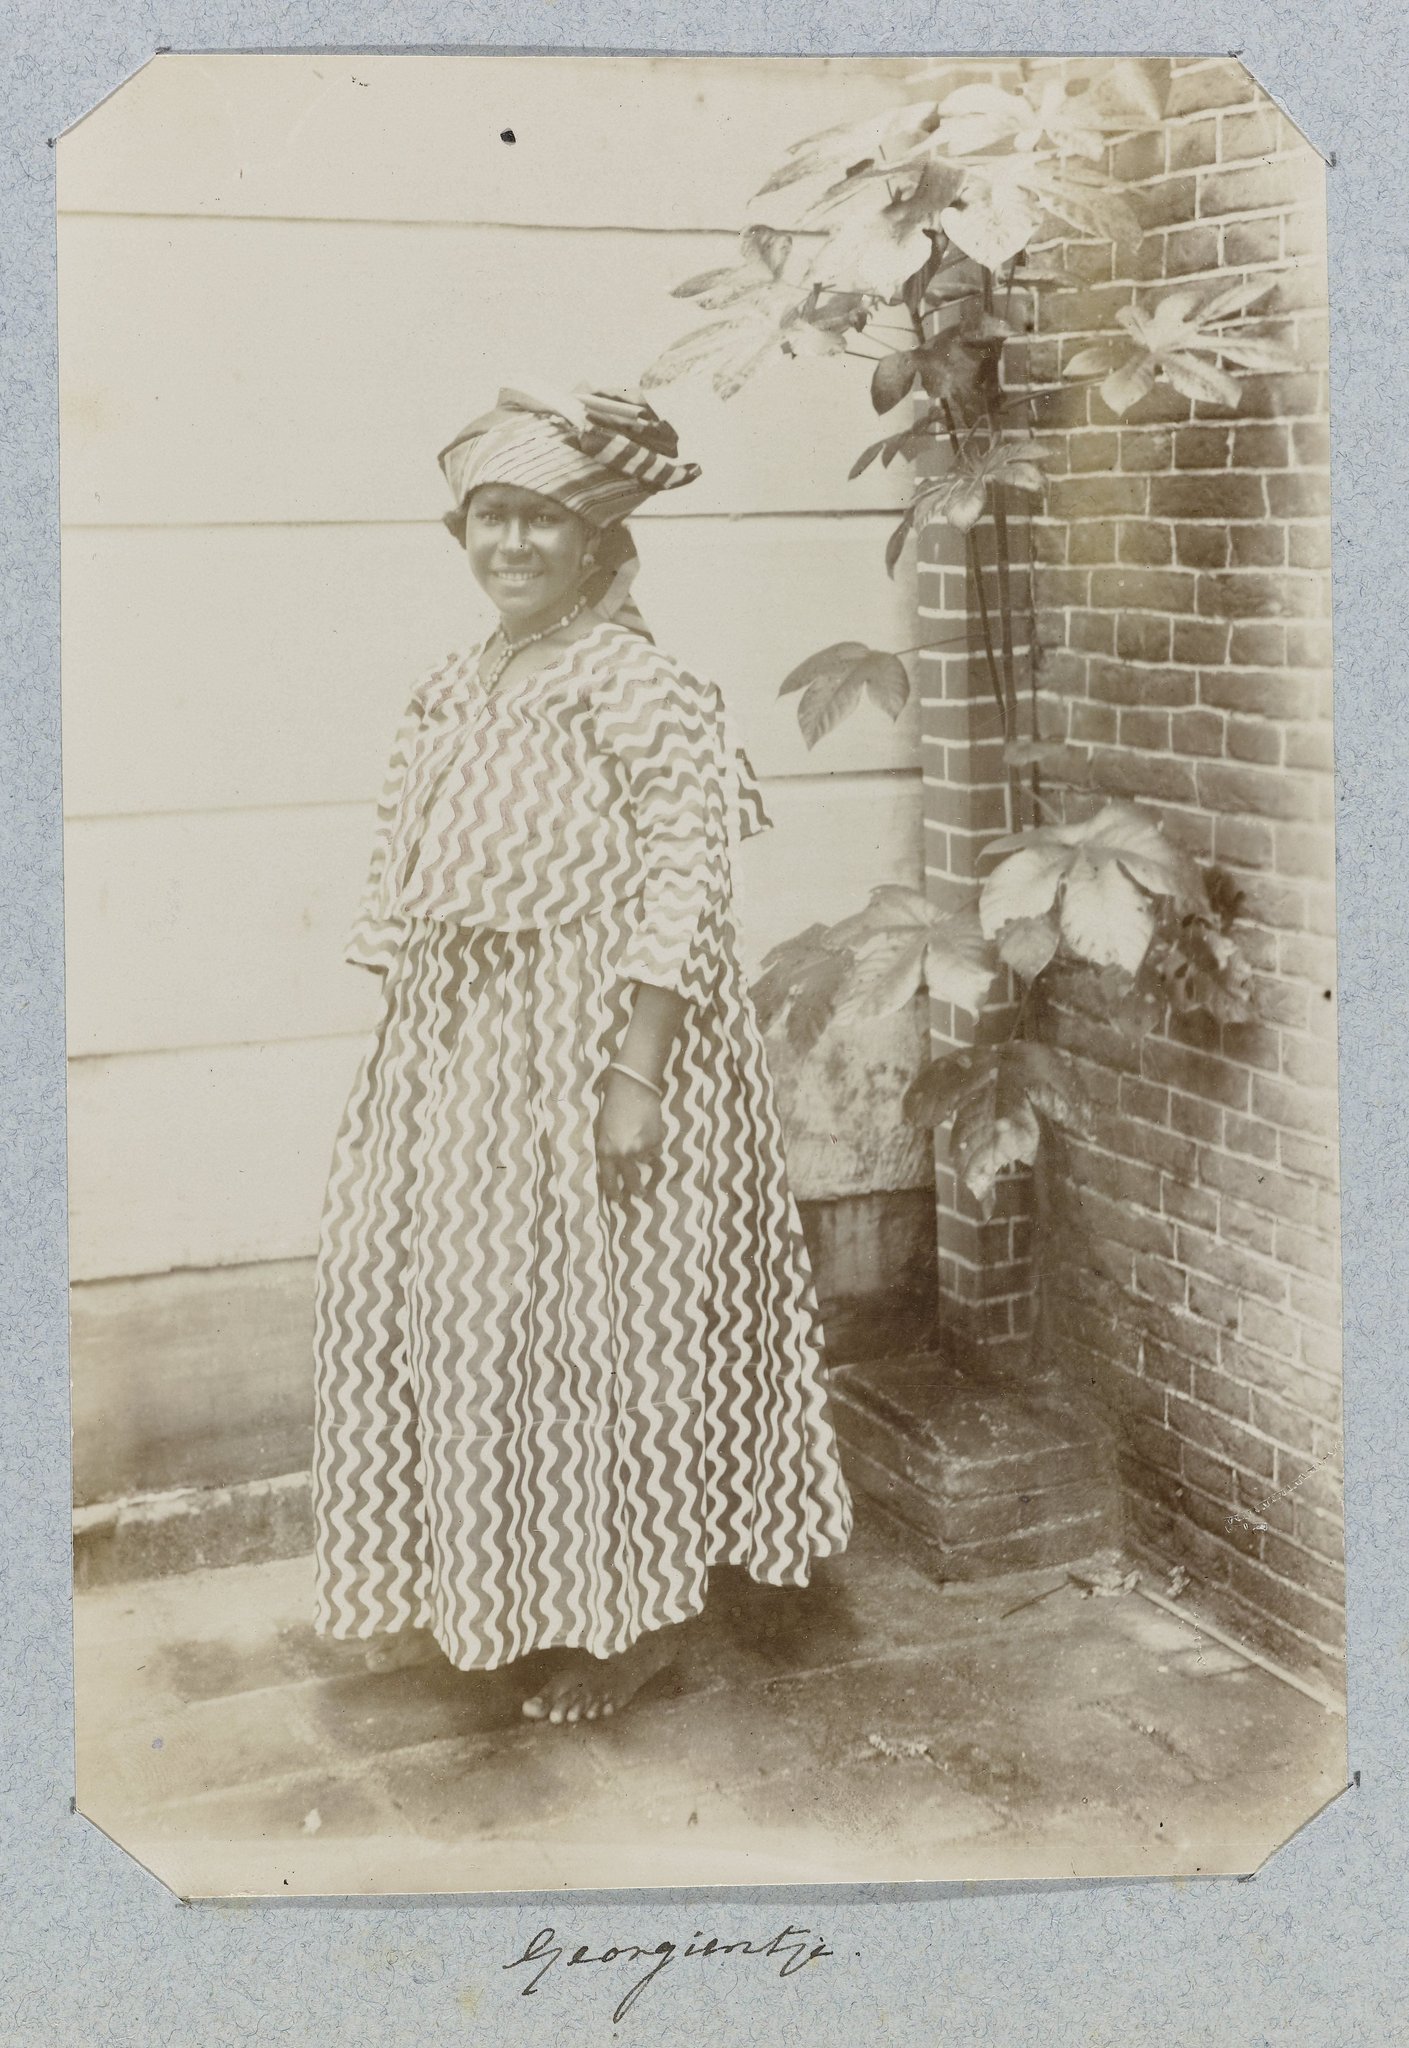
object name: photograph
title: Georgientje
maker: théodore van lelyveld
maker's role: painter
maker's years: 1867-1954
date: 1895-1898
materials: photographic support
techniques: collodion silver print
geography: suriname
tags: historical persons - bb - woman, suriname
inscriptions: inscription: ‘Georgientje’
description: Portret van de Surinaamse vrouw genaamd Georgientje, gekleed in kotomisi. Fotoafdruk in een fotoalbum van Théodore van Lelyveld over Suriname uit 1895-1898.